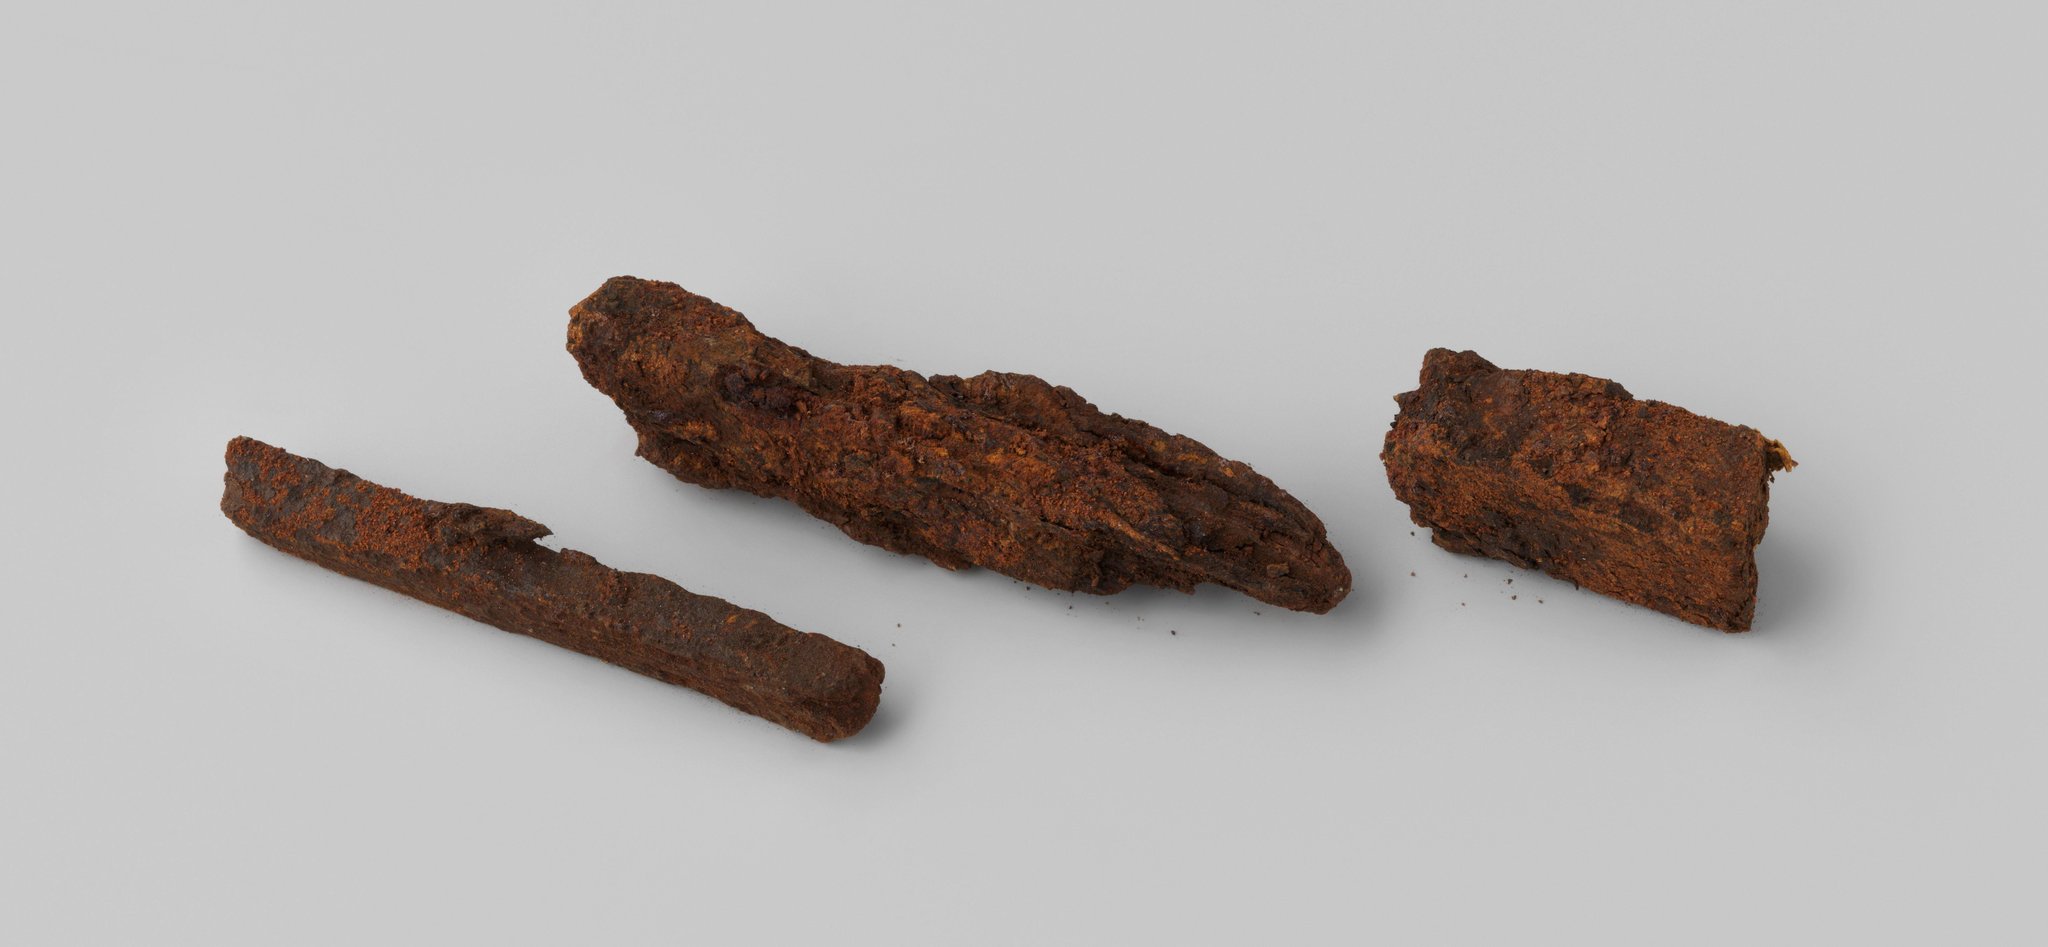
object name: part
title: Fragmenten of onderdelen uit het wrak van de Oost-Indiëvaarder Hollandia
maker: Anonymous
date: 1743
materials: iron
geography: netherlands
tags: verenigde oostindische compagnie, hollandia (schip), annet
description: Varied parts or fragments, bar(-shaped) fragments; fragm, eroded, broken: sim. 80H1763.